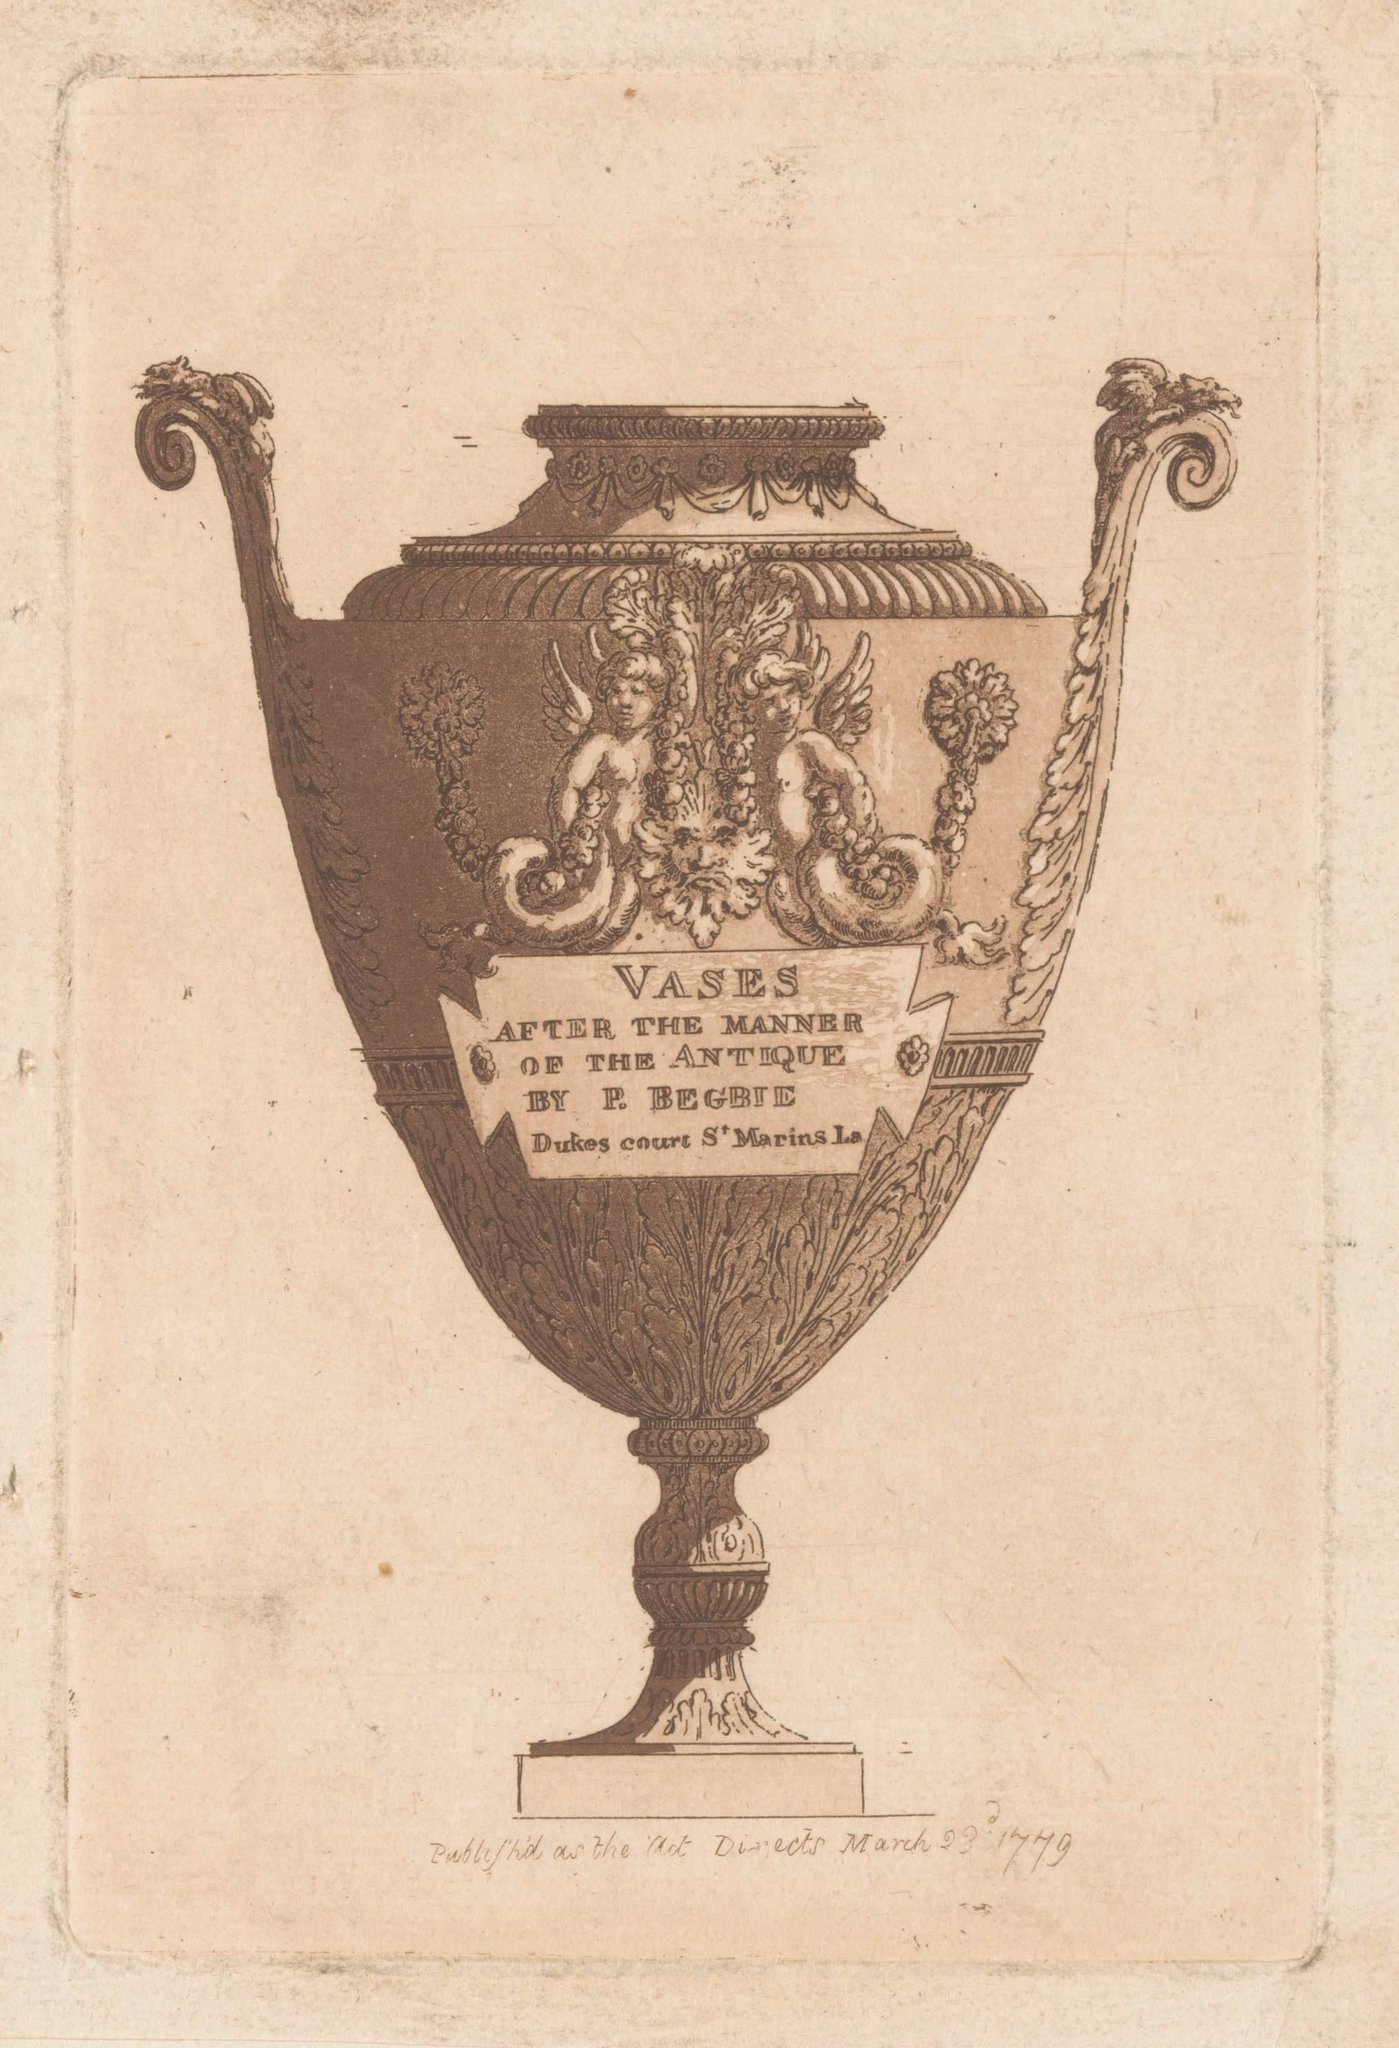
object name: print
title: Antieke vaas met tritons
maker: patrick begbie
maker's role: print maker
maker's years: -1820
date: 1779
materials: paper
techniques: aquatint, etching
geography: london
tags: triton(s), vase ~ ornament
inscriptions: collector's mark: Lugt 2760, collector's mark: Lugt 2228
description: Een antieke geornamenteerde vaas met twee tritonen en de serietitel.